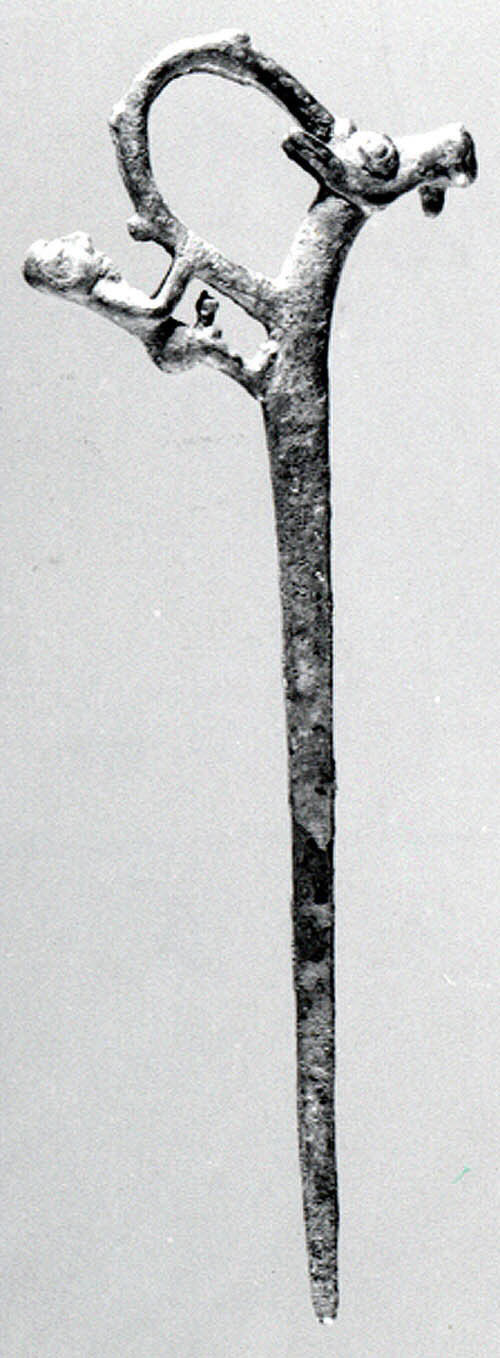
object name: pin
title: Pin with a nude male and an ibex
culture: iranian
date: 800-601 BCE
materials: bronze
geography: iran, probably from luristan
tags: male nudes,ibex